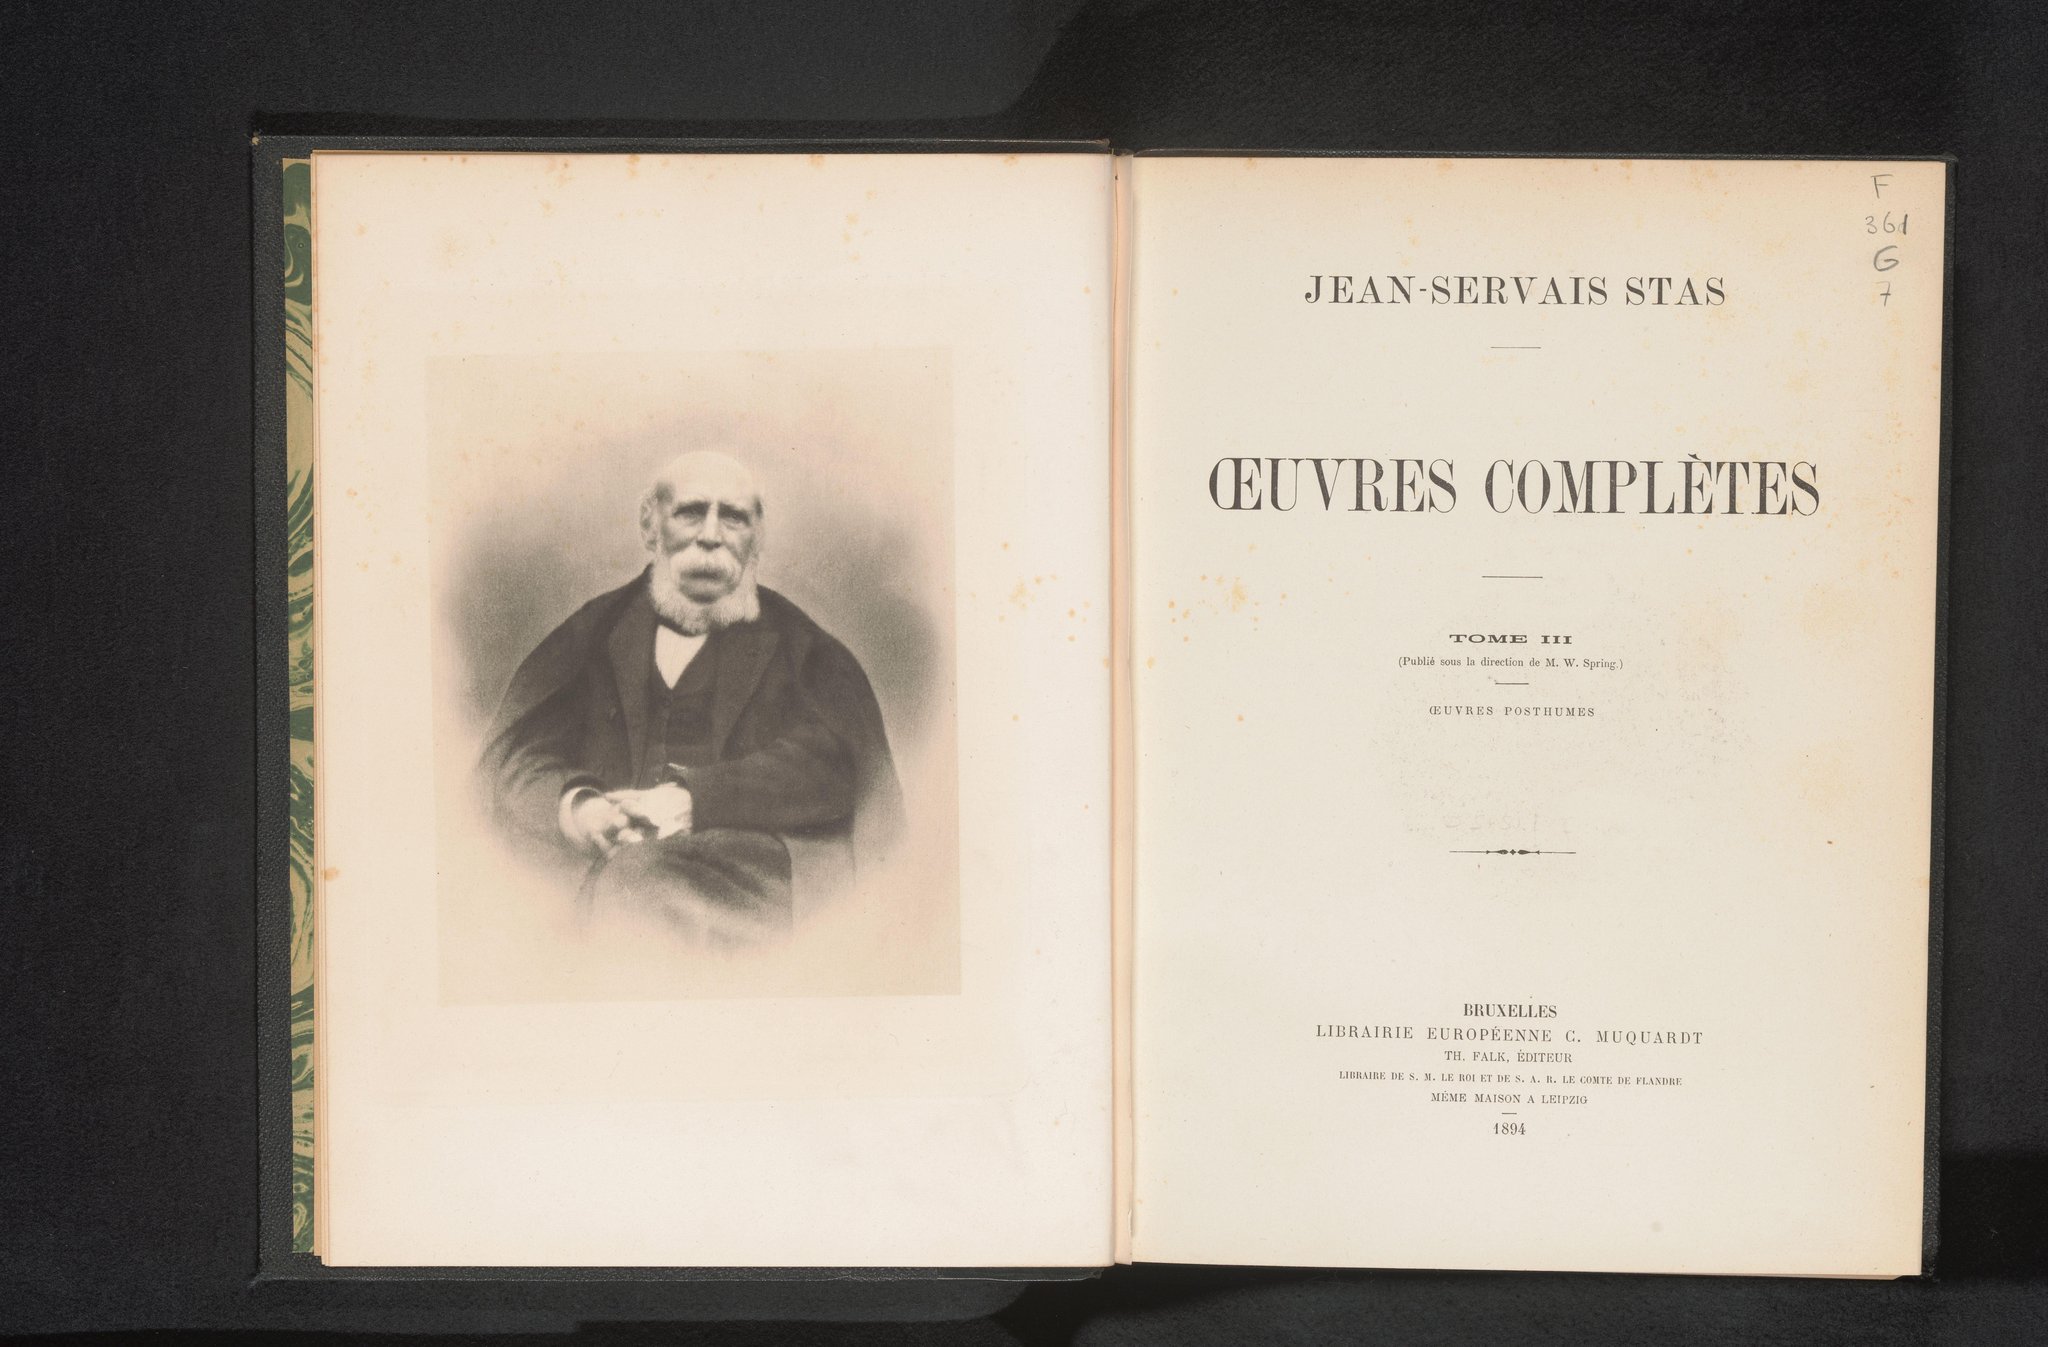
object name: photomechanical print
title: Portret van Jean Stas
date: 1889-1894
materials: paper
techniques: photoaquatint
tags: louvain, brussels, historical persons